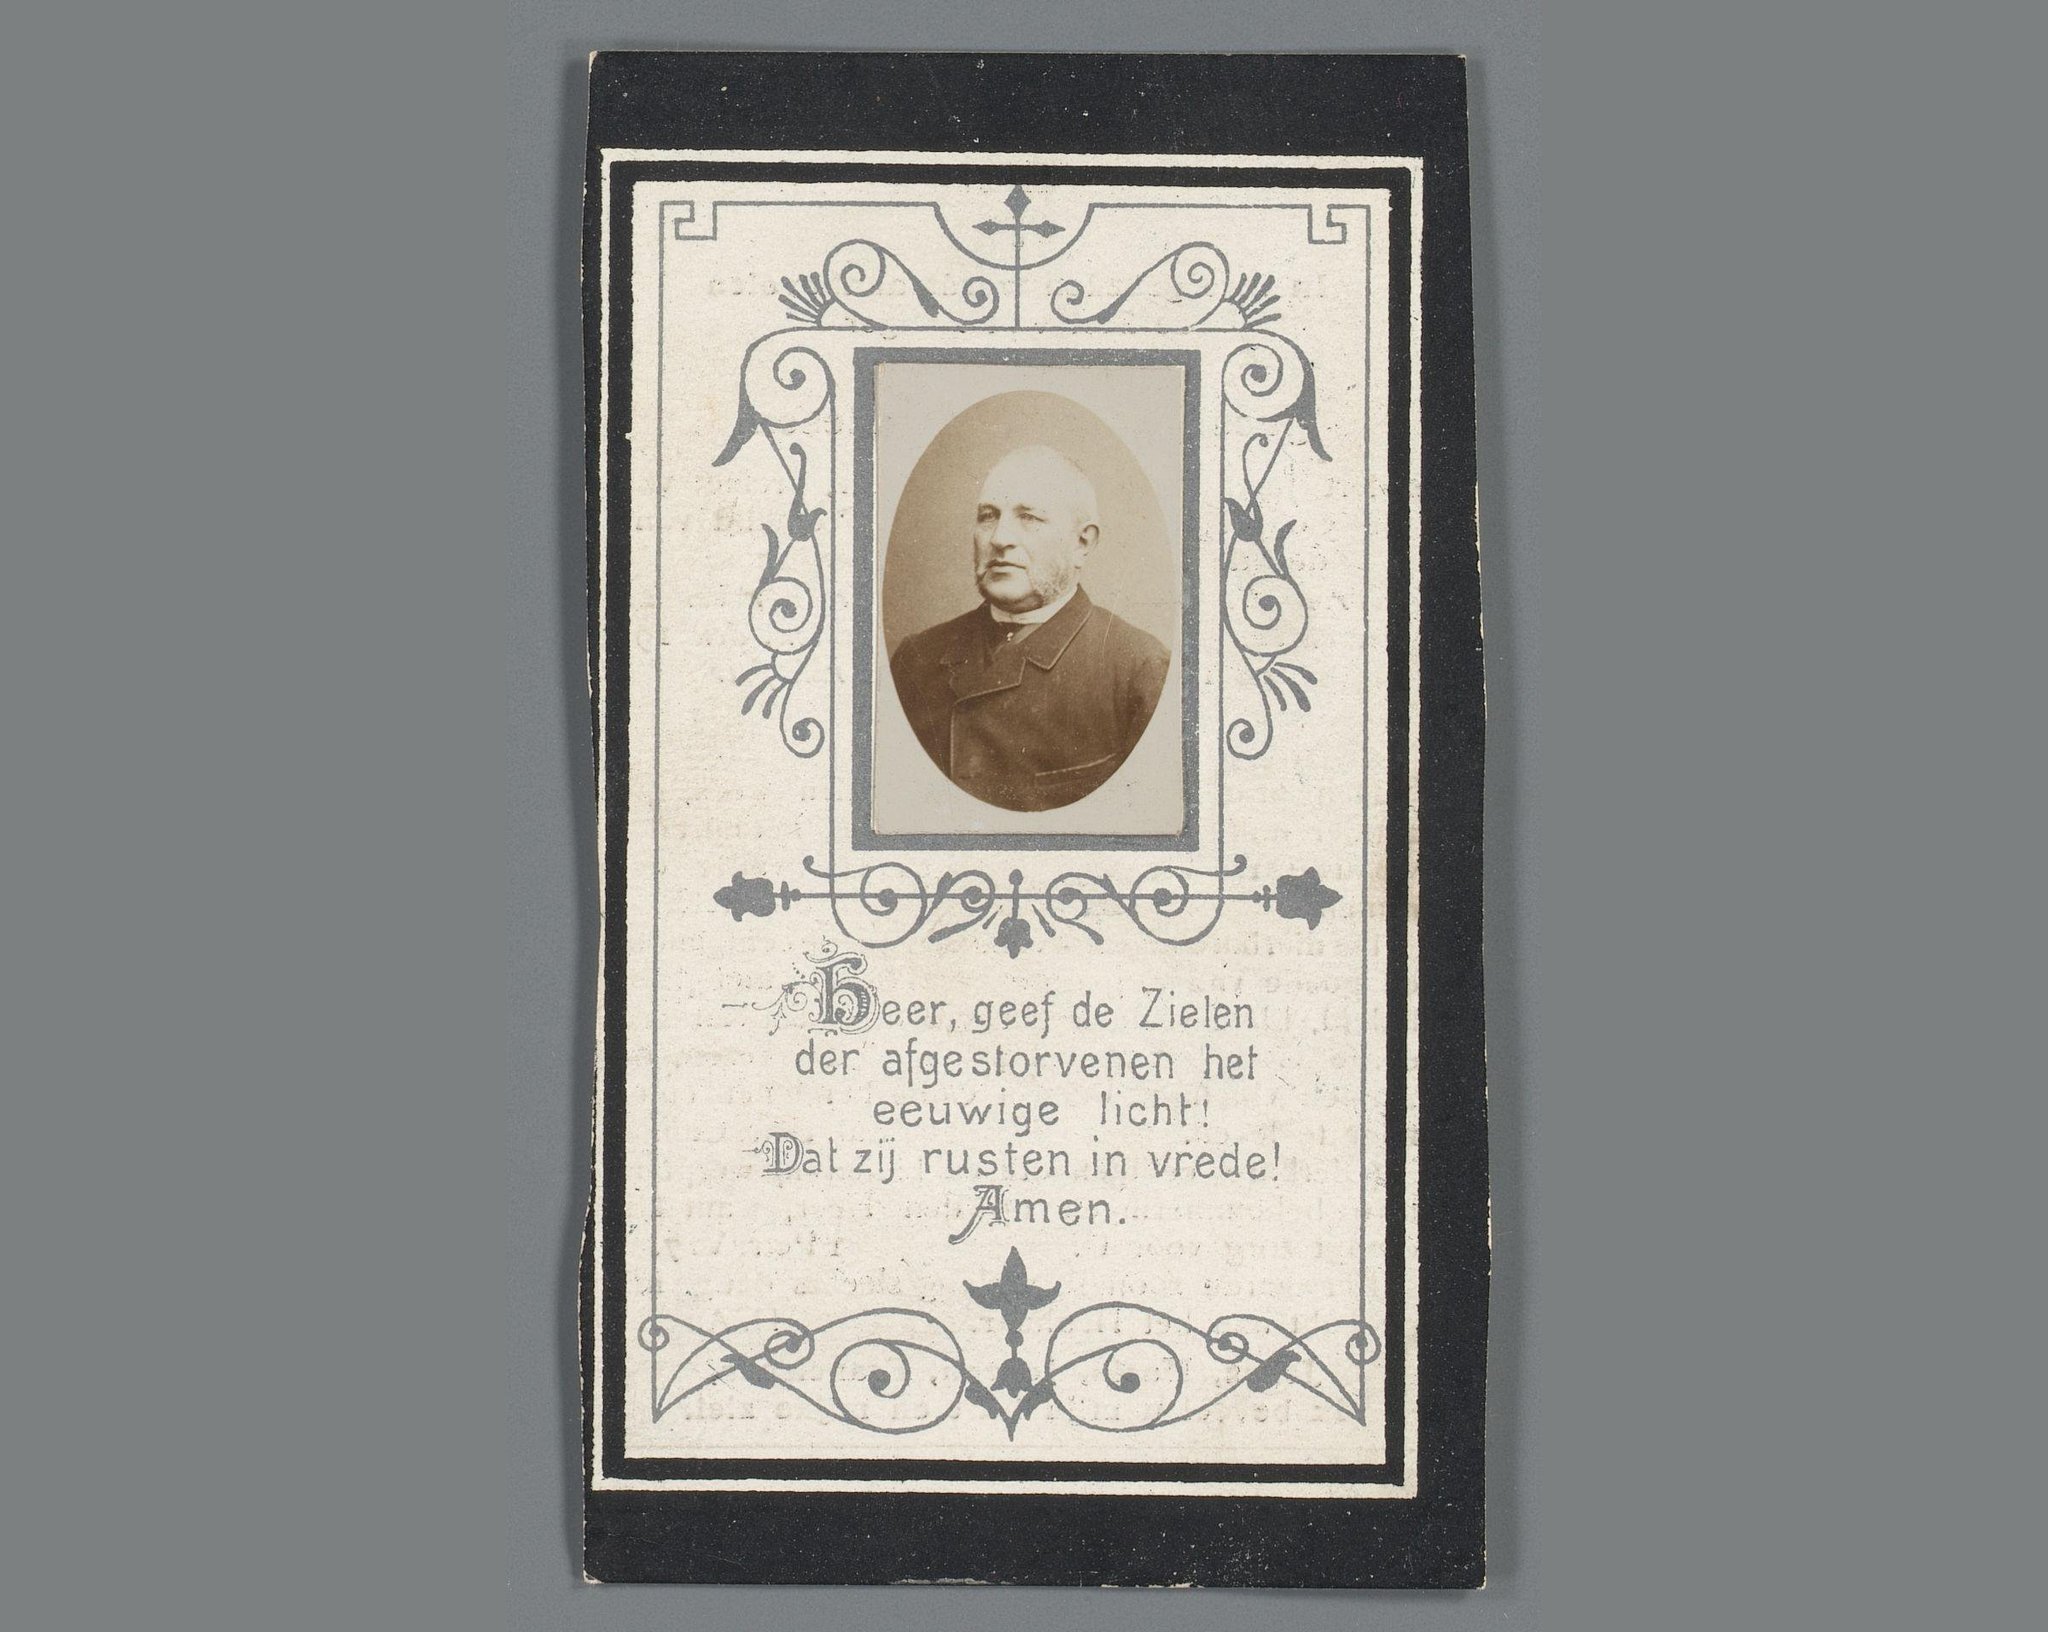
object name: photograph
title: Portret van Jacobus Joannes Driesen op bidprent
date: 1901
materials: paper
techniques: letterpress printing, lithograph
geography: schoonhoven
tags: adult man, historical persons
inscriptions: inscription: ‘In uwe gebeden wordt aanbevolen/ de Ziel van Zaliger (...) Jesus, Maria, Joseph, Franciscus,/ ik beveel u mijn hart en mijne ziel./ R.K. Boekh. van F.J. Soeters, te Schoonhoven.’, inscription: ‘Heer, geef de Zielen/ der afgestorvenen het/ eeuwige licht!/ Dat zij rusten in vrede!/ Amen.’